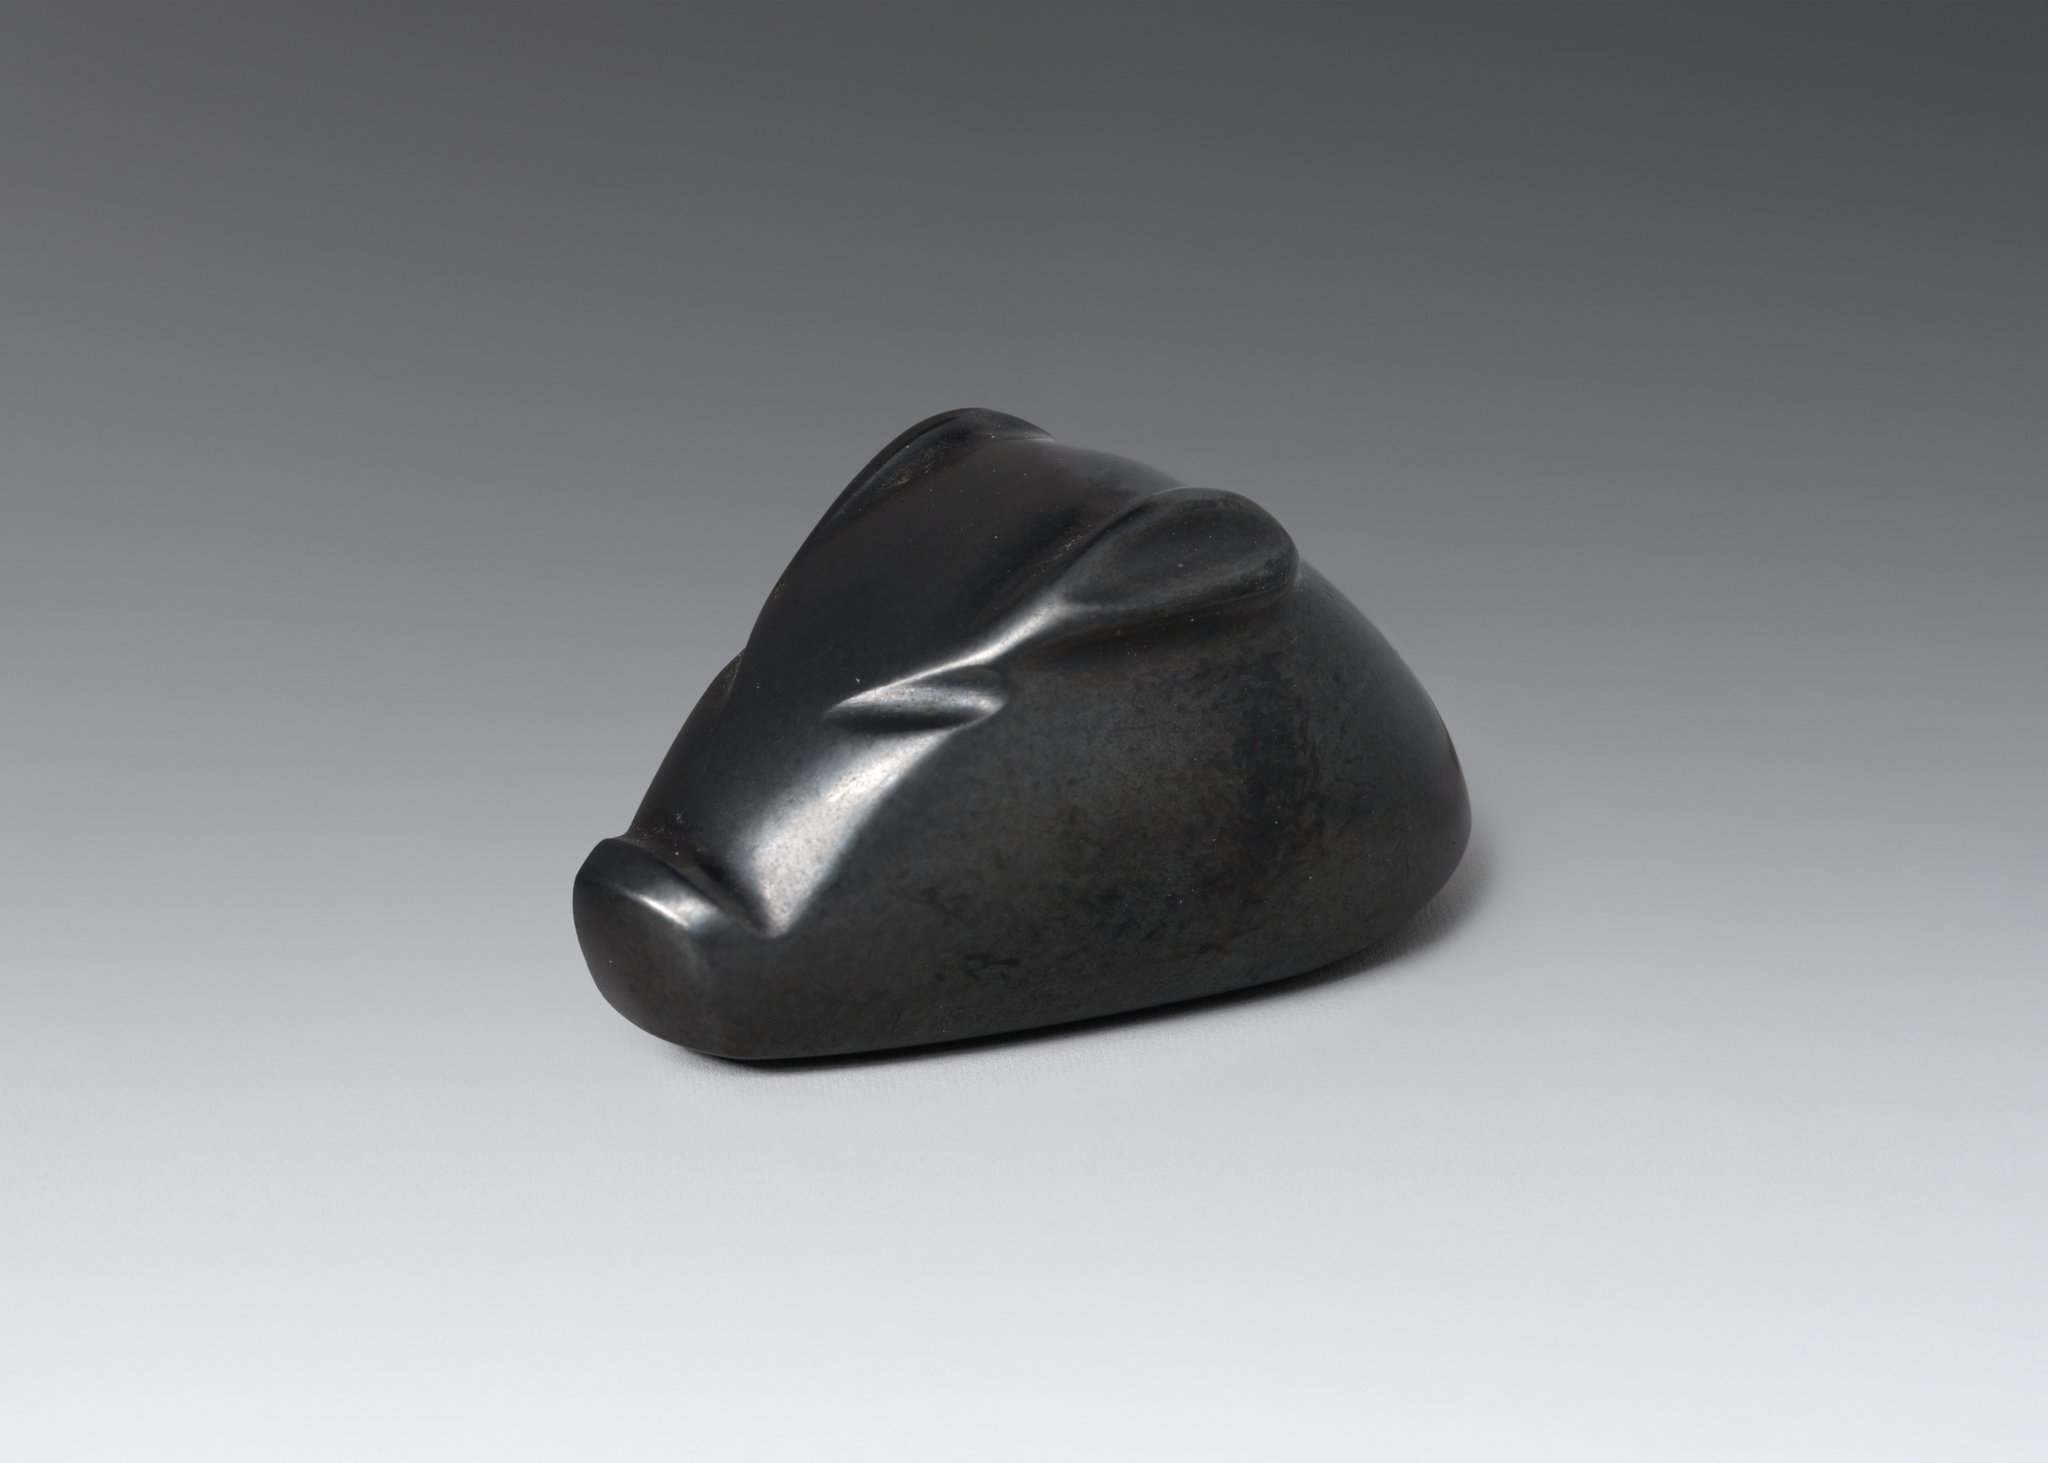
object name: weight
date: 2000-1001 BCE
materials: mineral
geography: mesopotamia